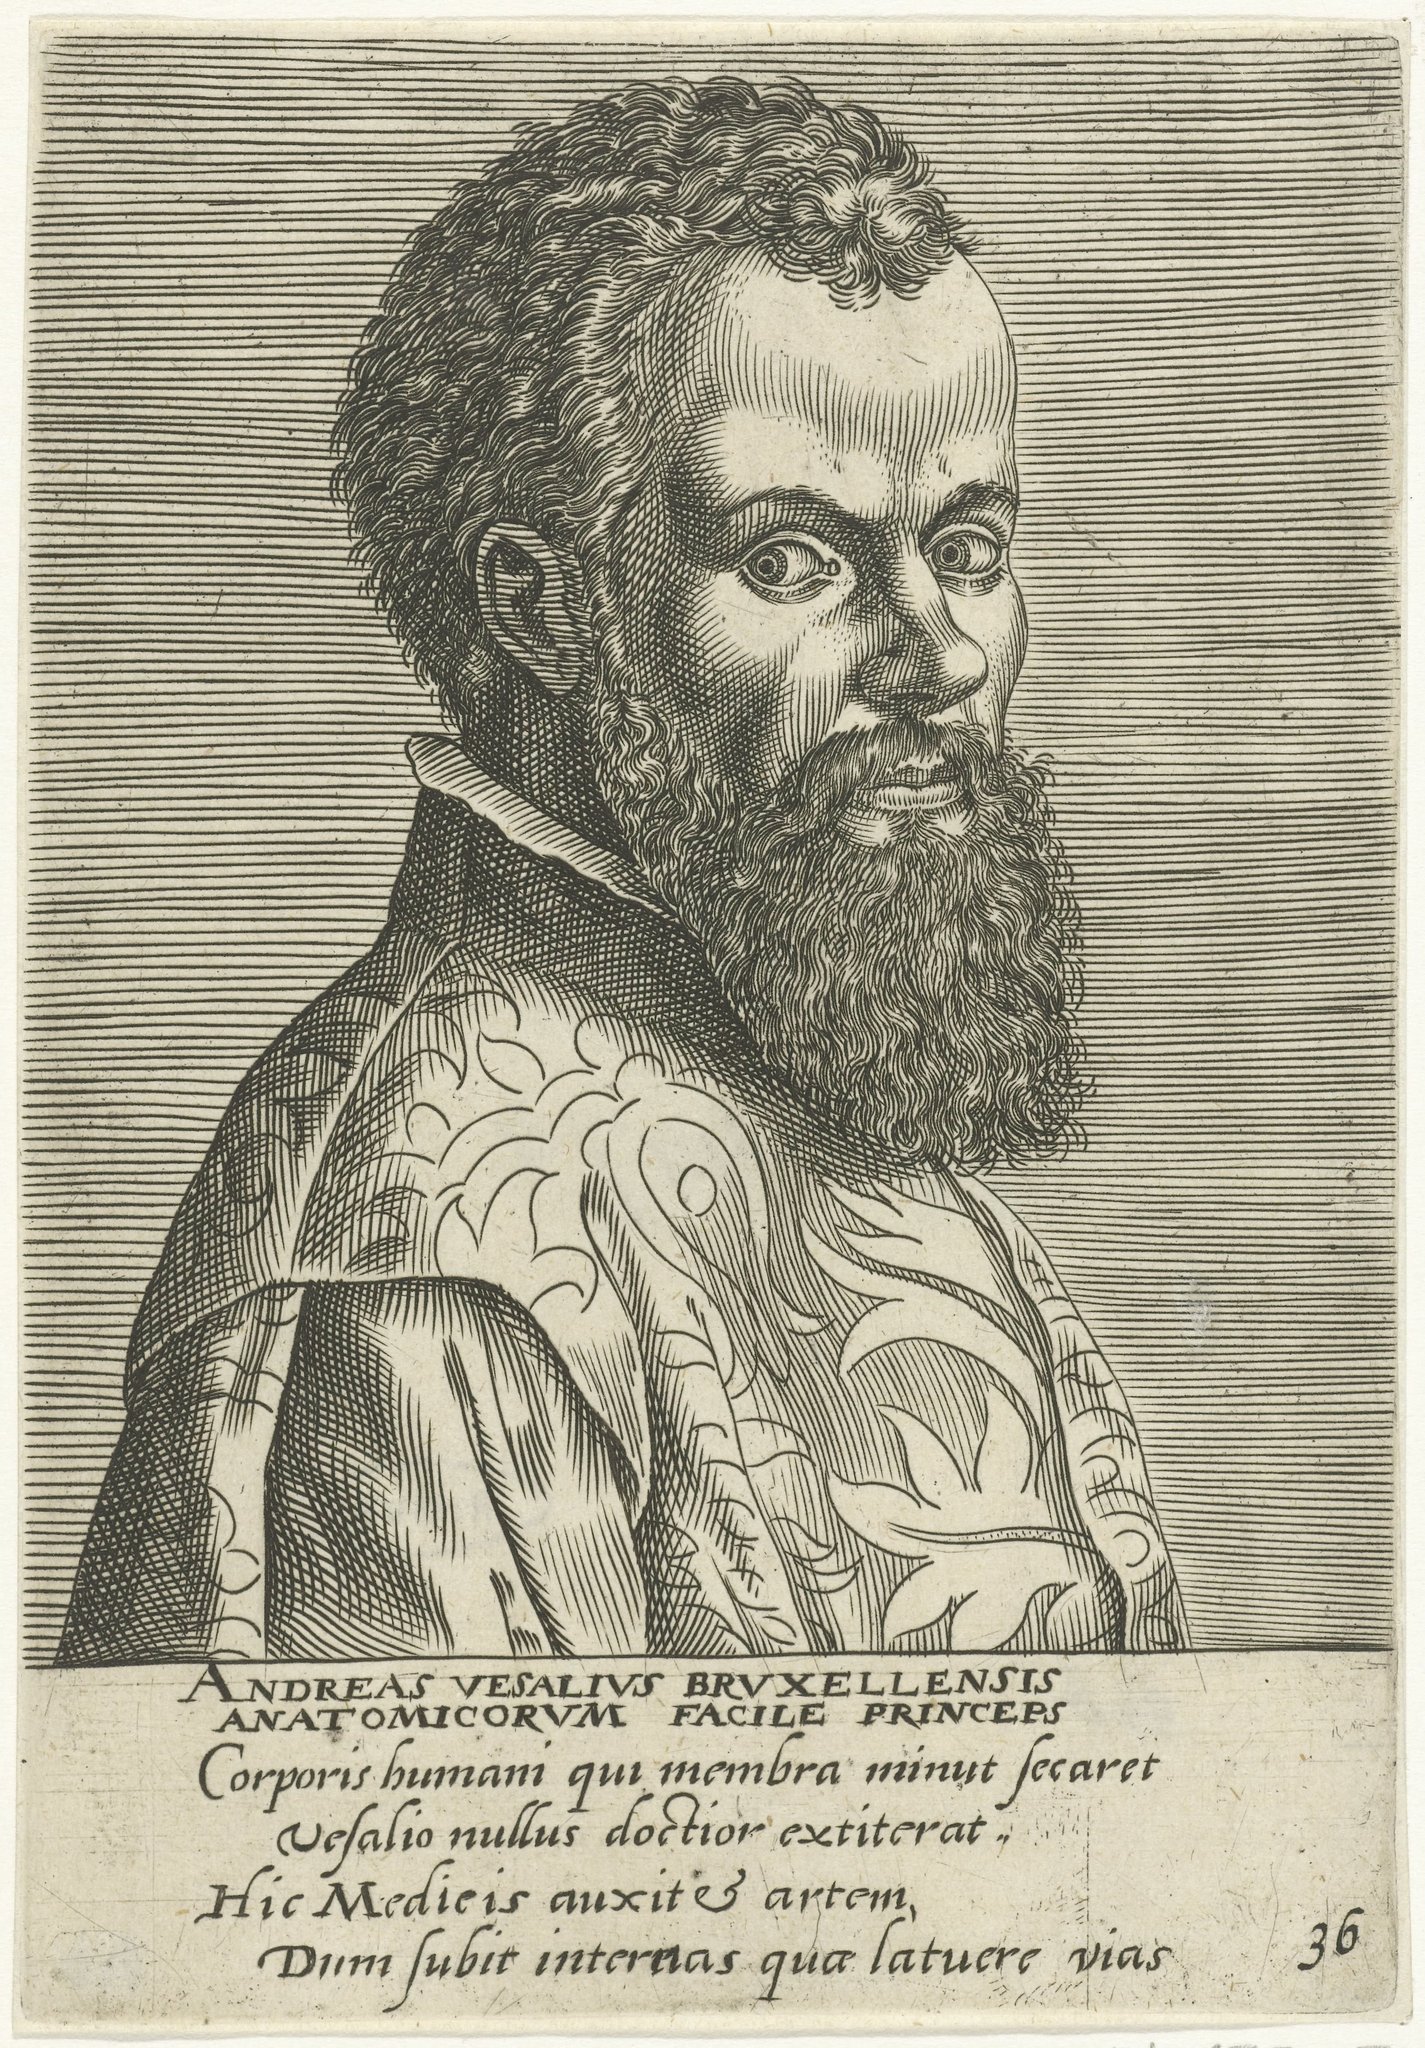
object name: print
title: Portret van Andreas Vesalius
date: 1572-1662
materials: paper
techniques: engraving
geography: antwerp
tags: brussels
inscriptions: collector's mark: Lugt 2228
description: Portret van Andreas Vesalius, Brusselse anatoom en arts. Buste naar rechts. De prent heeft een Latijns onderschrift.